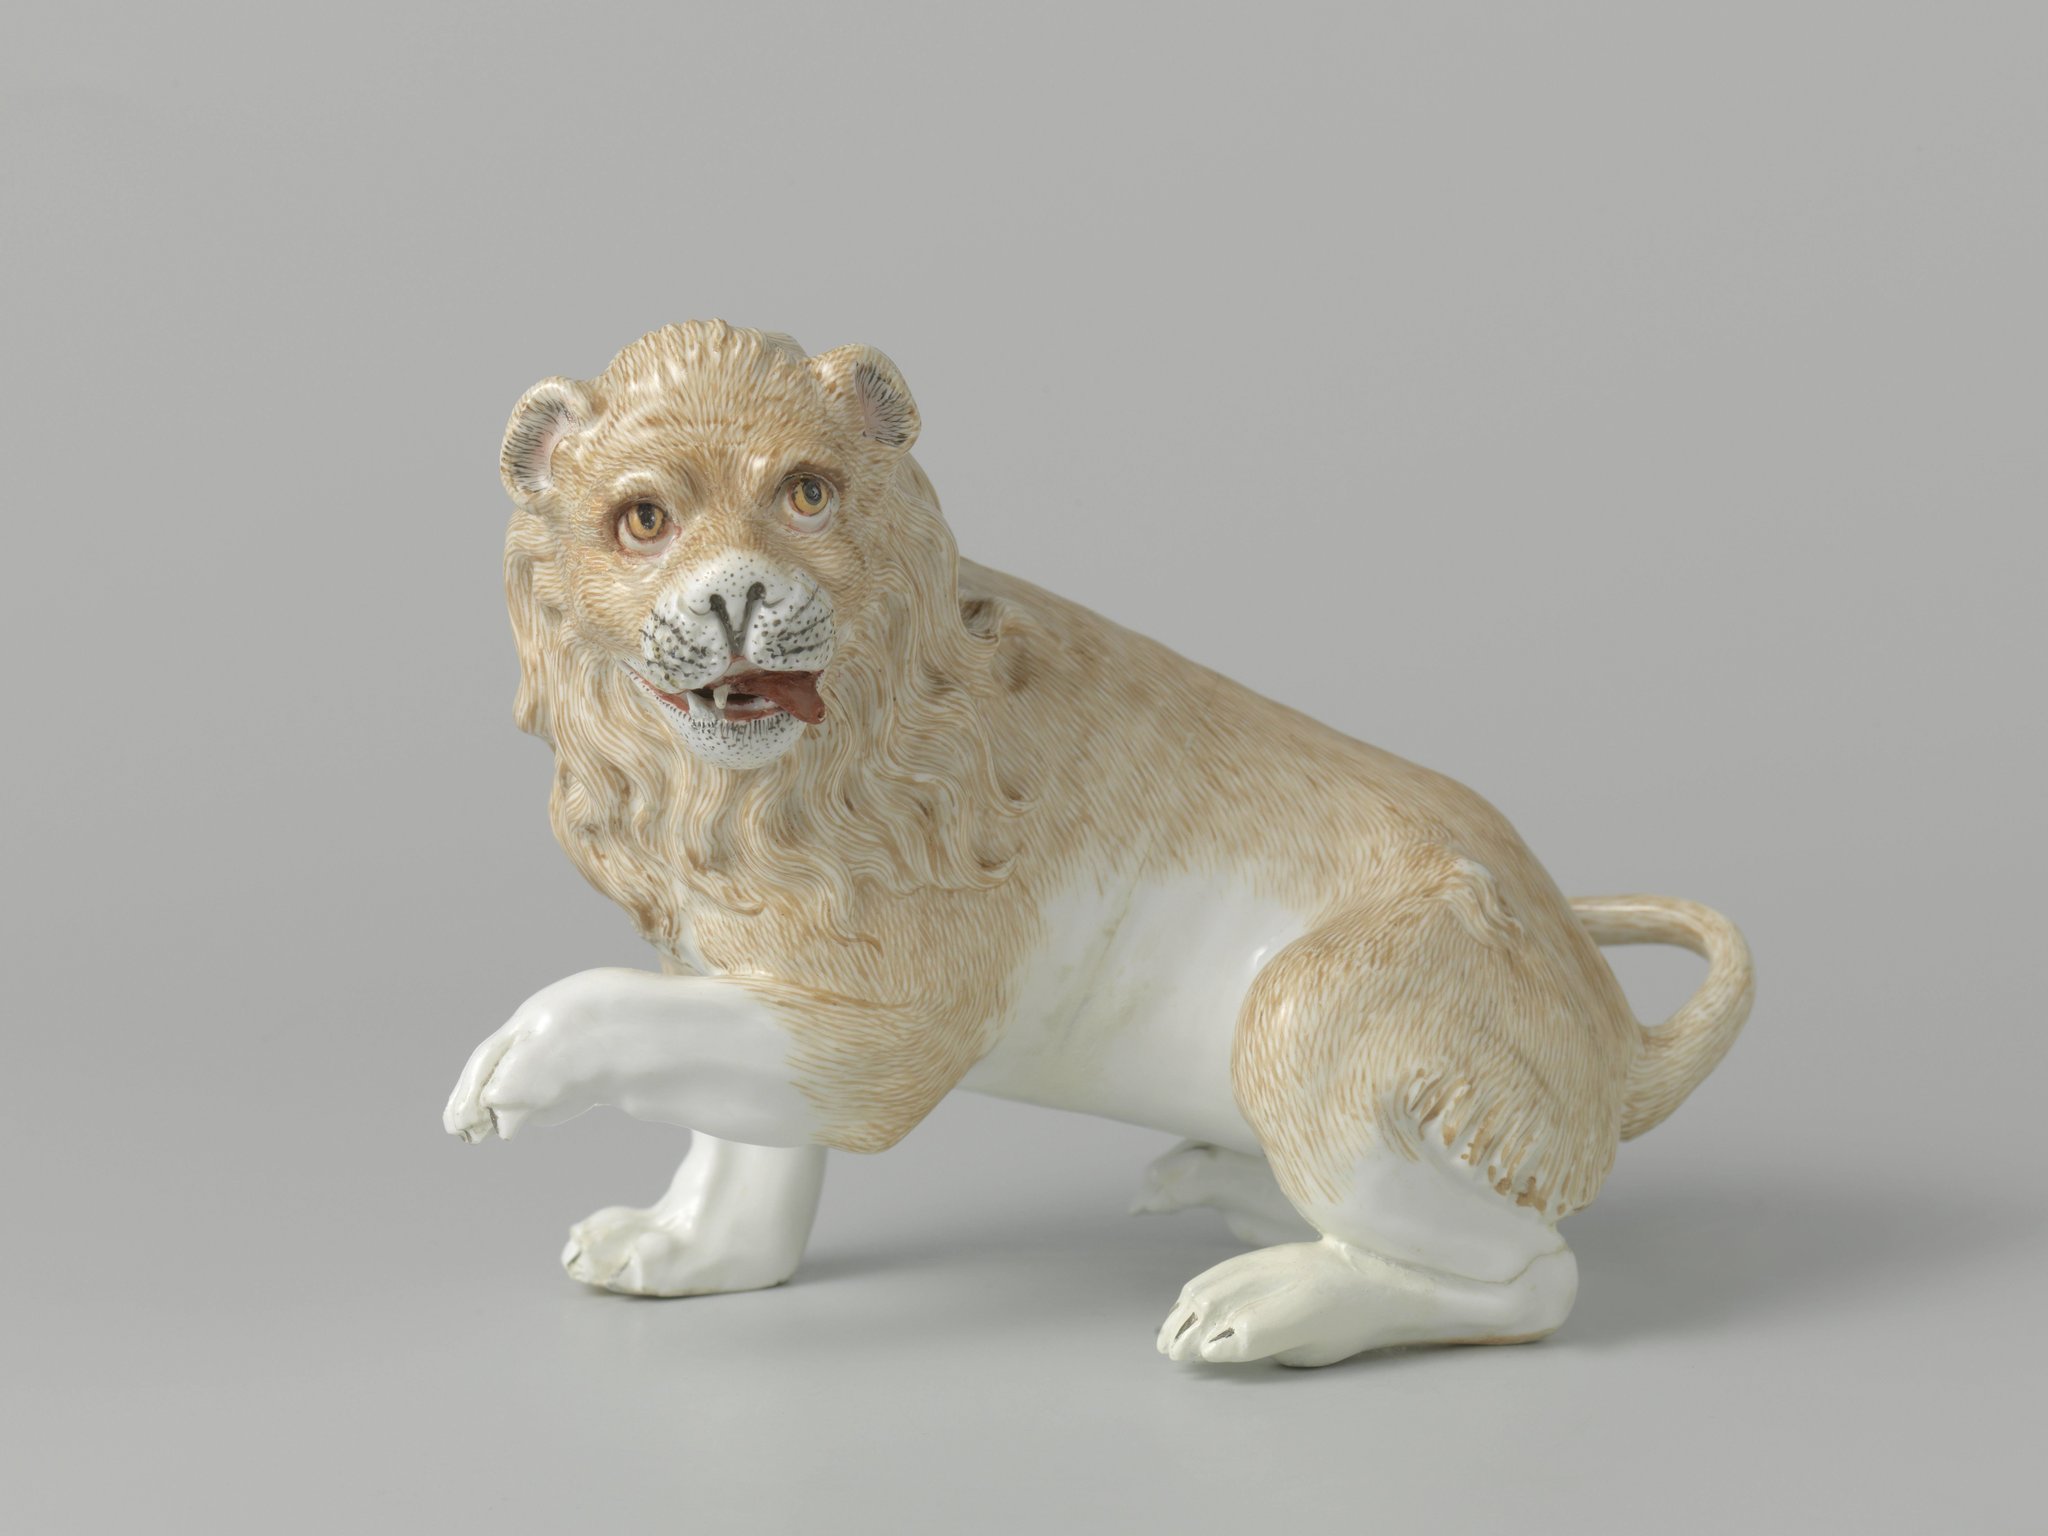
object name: figure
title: Figure of a seated lion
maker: wilhelm caspar wegely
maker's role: porcelain company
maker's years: 1714-1764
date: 1752-1757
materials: glaze, paint, porcelain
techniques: firing, forming, vitrification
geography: berlin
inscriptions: mark: ‘1/109/26’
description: Een leeuw en een leeuwin. Porselein Berlijn, ca. 1752 - 1757, fabriek van Wilhelm Kaspar Wegely.